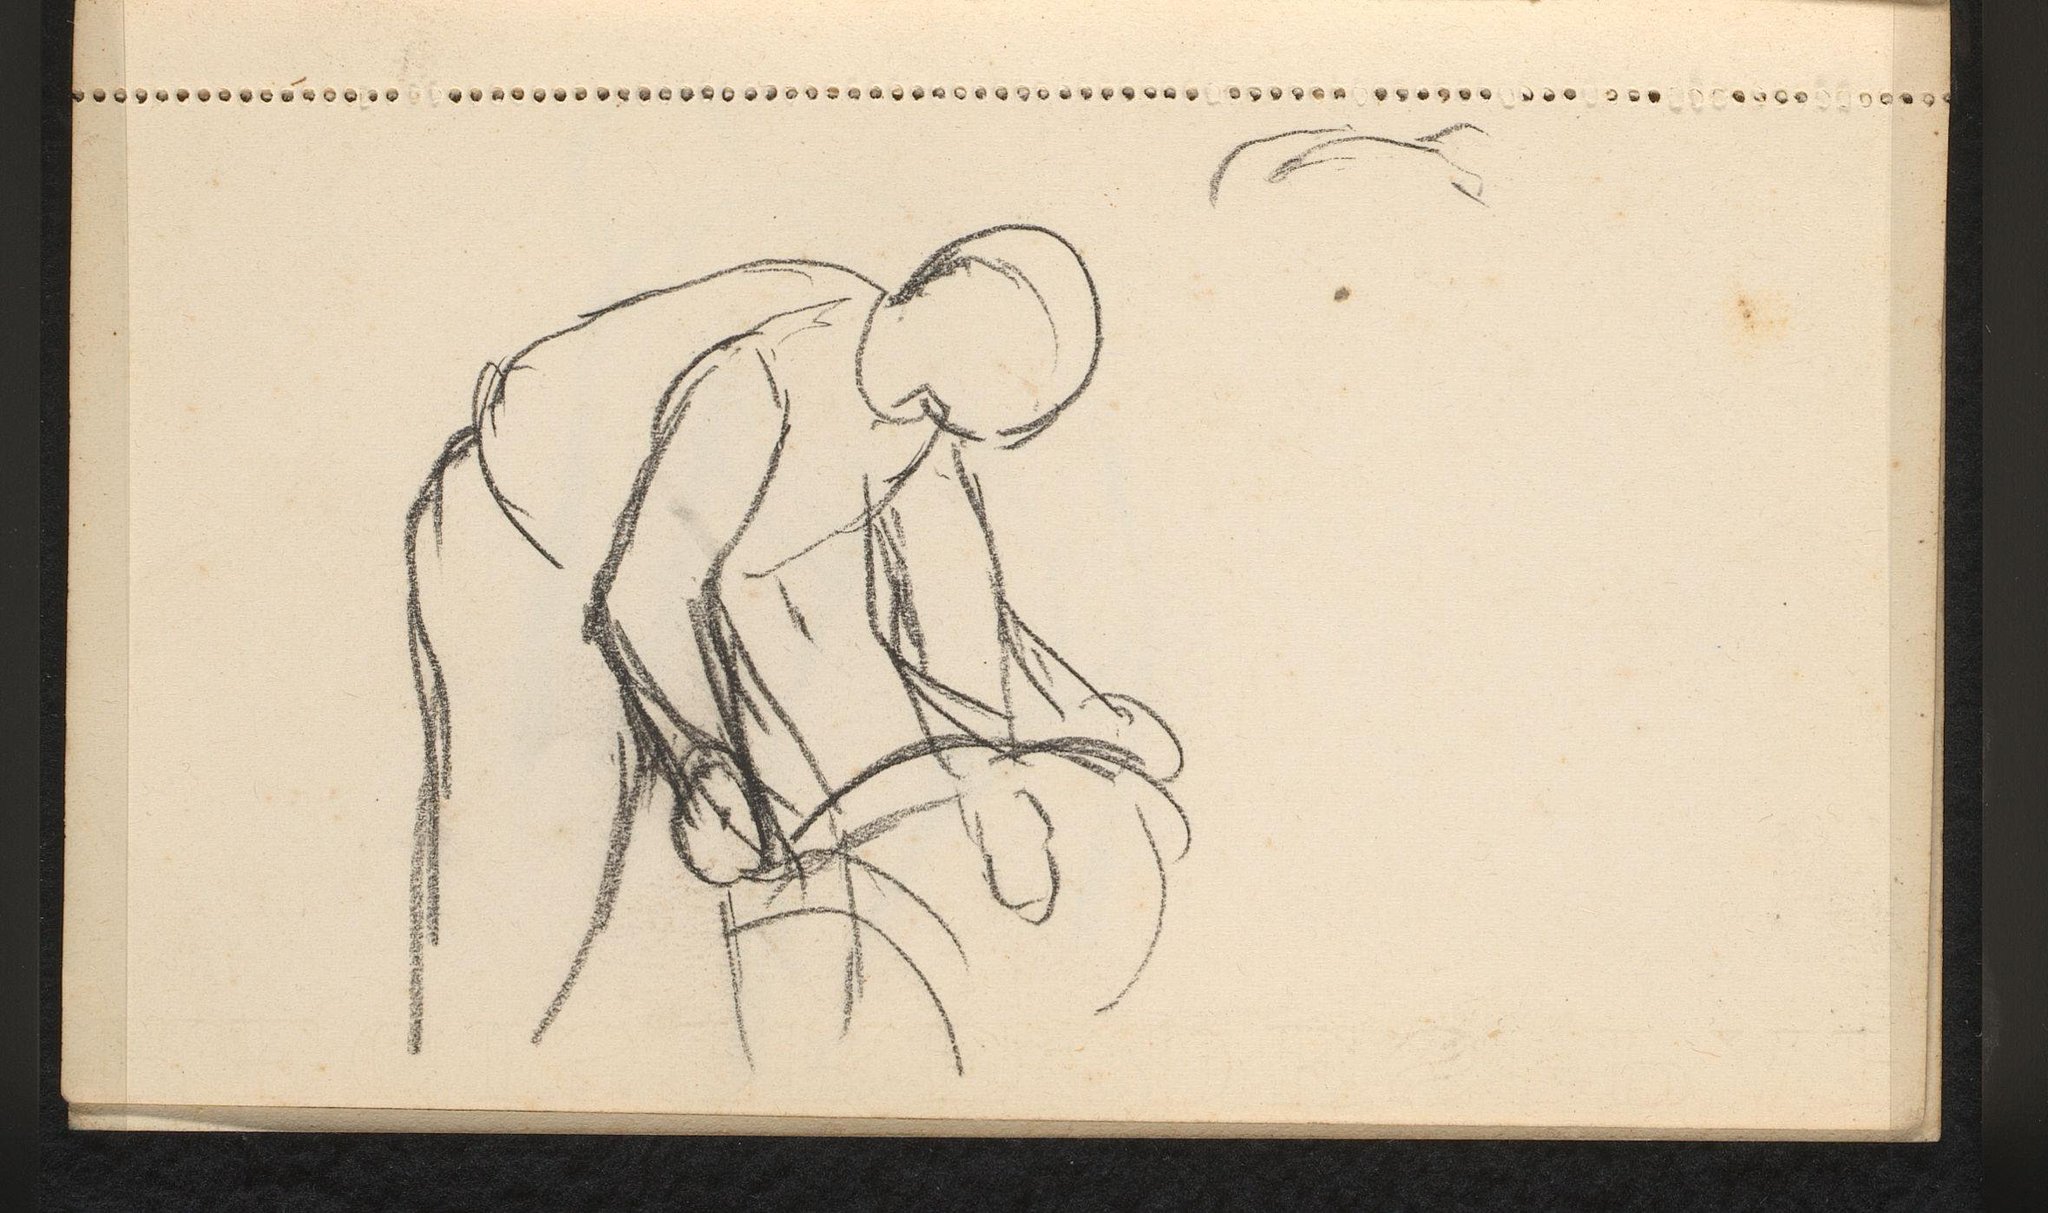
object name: sketchbook leaf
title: Voorovergebogen figuur met een vat of mand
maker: gerrit van blaaderen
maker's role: draughtsman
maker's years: 1873-1935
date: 1908-1927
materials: chalk, paper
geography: france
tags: containers, bending figure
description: Blad 32 recto uit een schetsboek met 33 bladen.